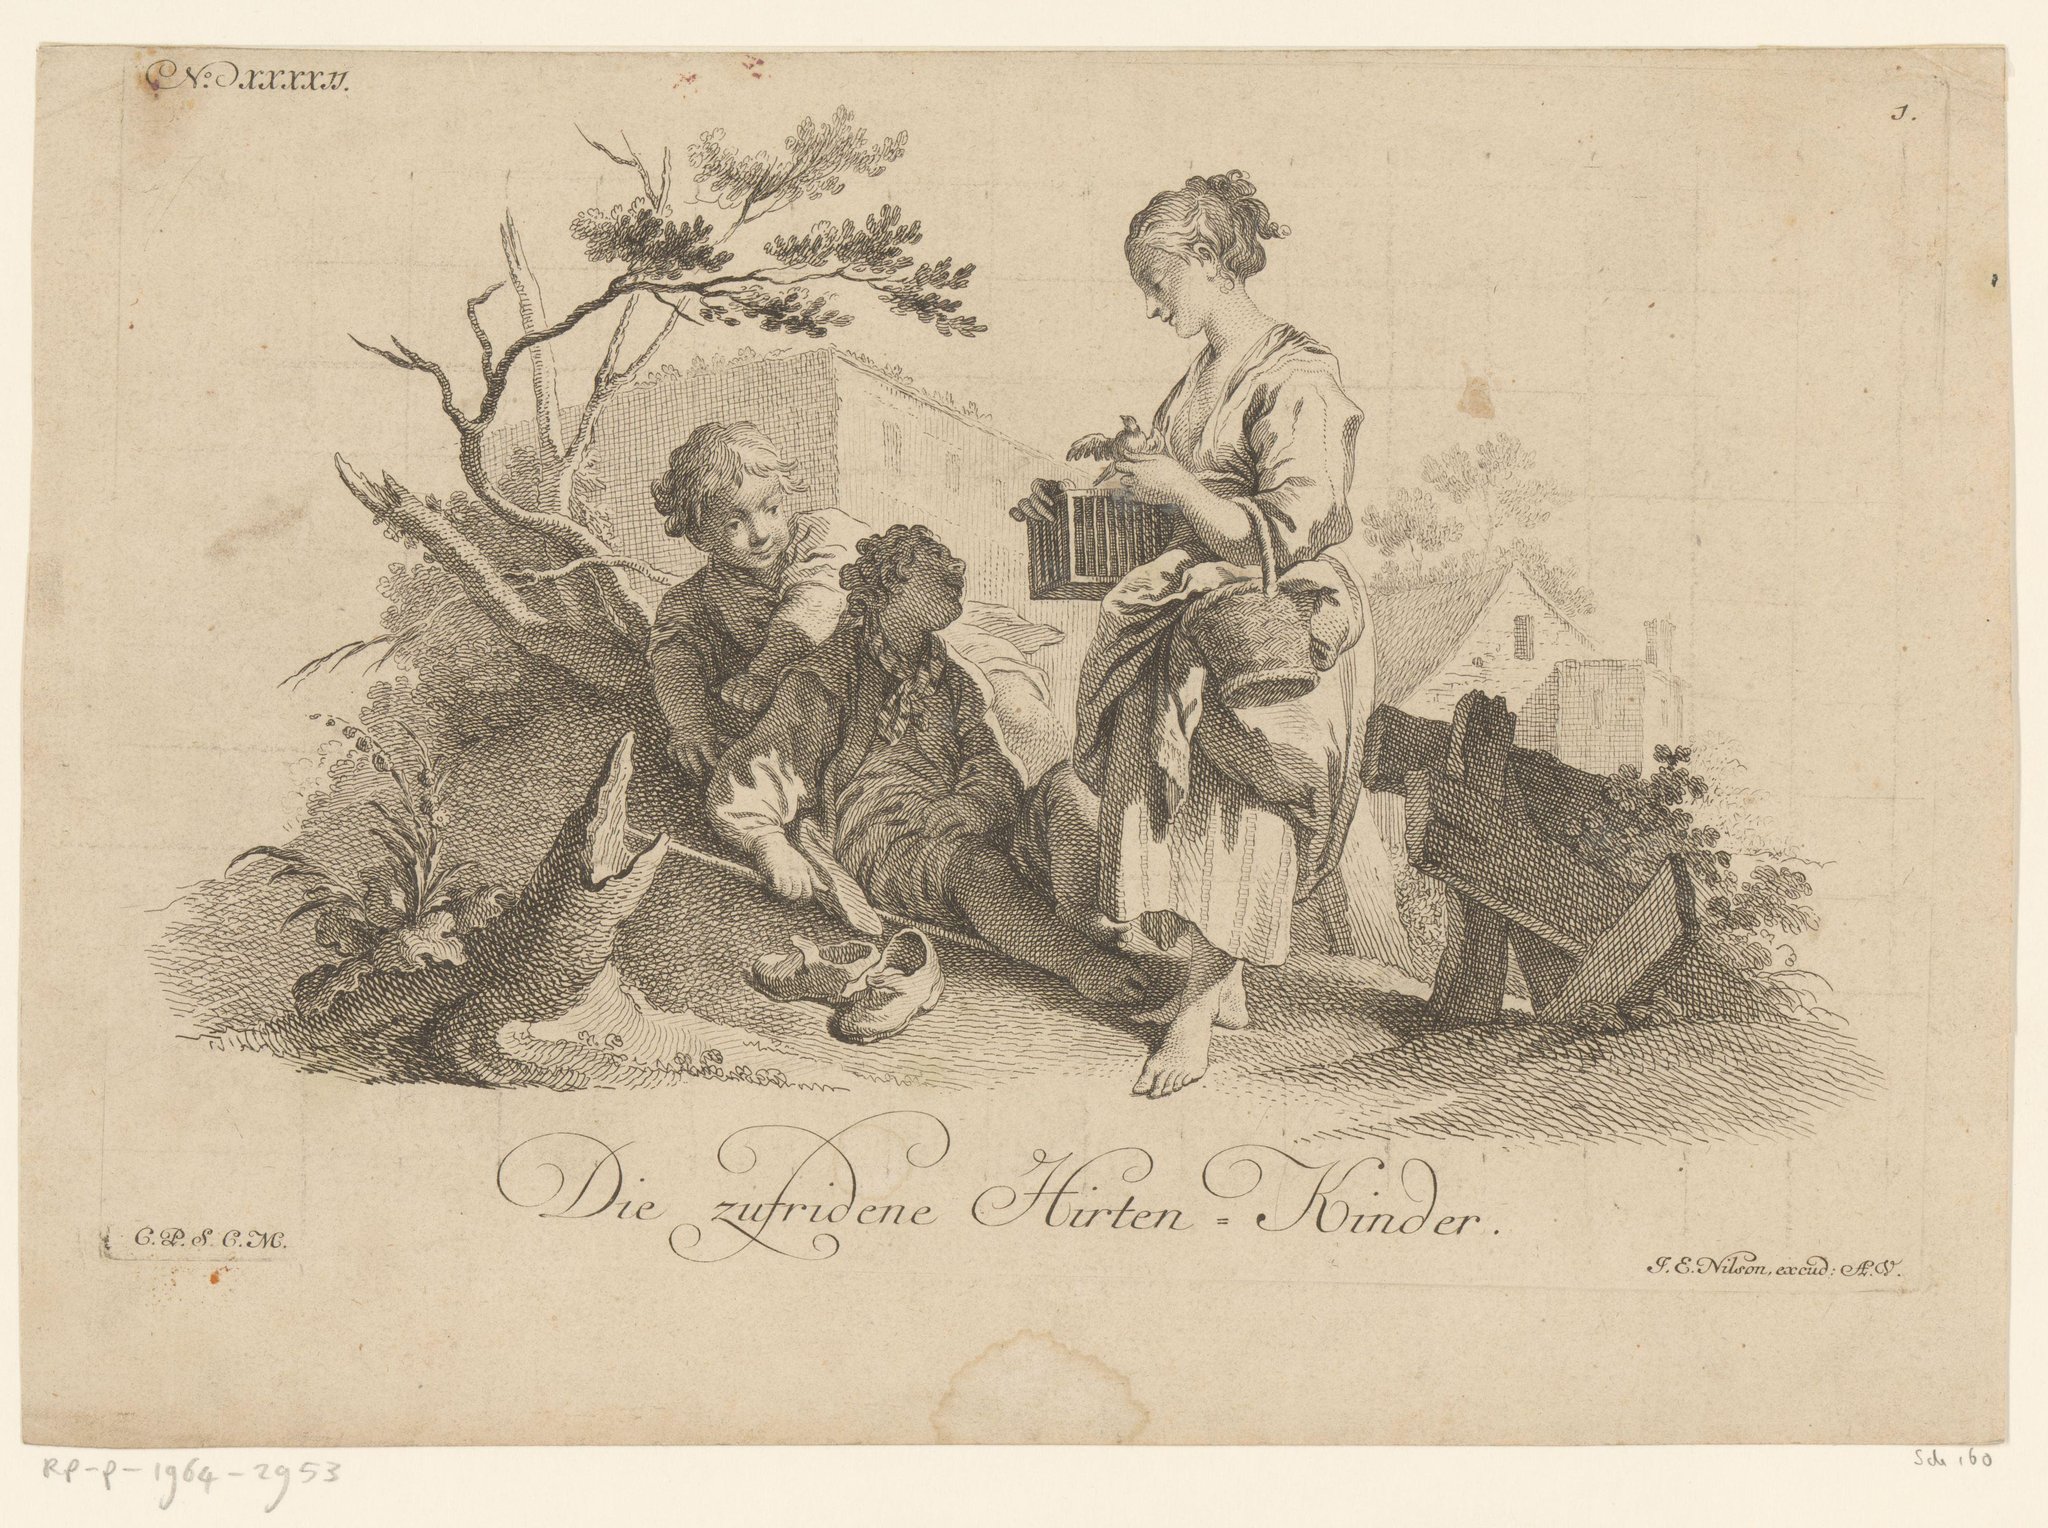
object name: print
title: Die zufriedene Hirten-Kinder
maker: johann esaias nilson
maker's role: draughtsman, print maker, publisher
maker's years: 1721-1788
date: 1731-1788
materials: paper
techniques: engraving, etching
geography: augsburg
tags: adolescent, young woman, maiden, herding, herdsman, herdswoman, shepherd, shepherdess, cowherd, etc., bird-cage opened (loss of virginity symbolized)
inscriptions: collector's mark: Lugt 2760, collector's mark: Lugt 2228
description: Linksboven gedrukt nummer XXXXII en rechtsboven 1.